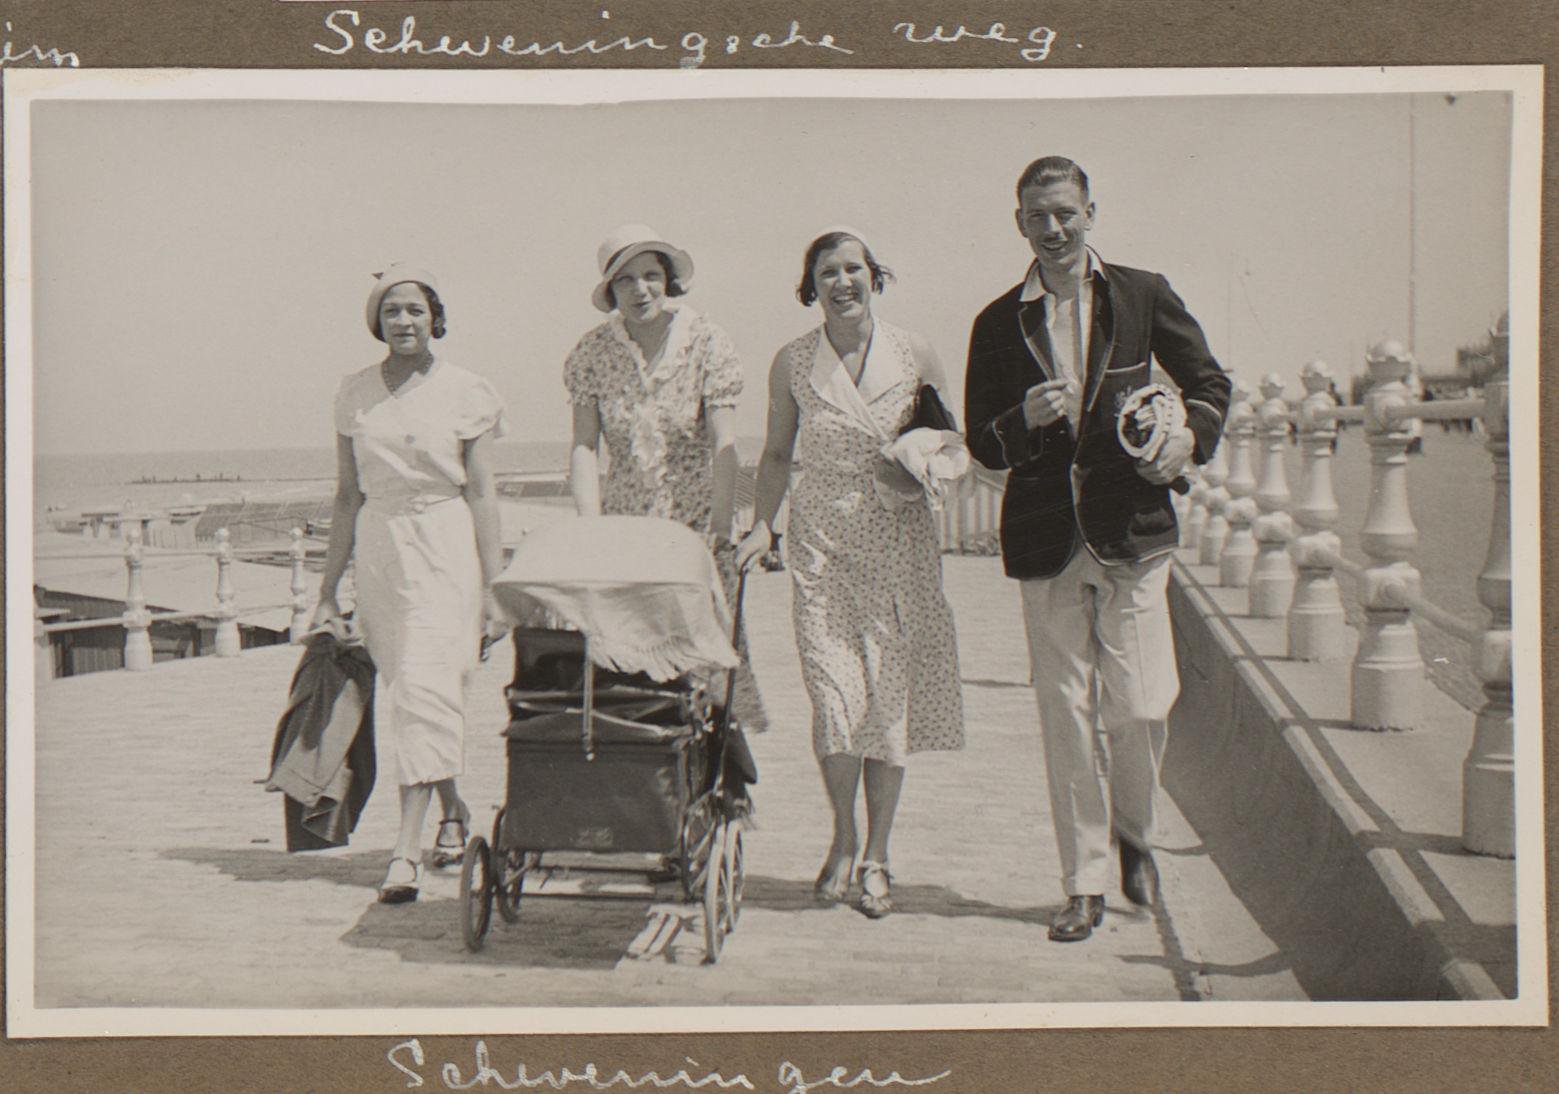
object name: photograph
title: Gezelschap lopend over de boulevard, Scheveningen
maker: Anonymous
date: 1932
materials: paper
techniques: gelatin silver print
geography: scheveningen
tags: the hague, wilhelmina van zijll de jong, strolling, avenue, boulevard, promenade, esplanade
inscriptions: inscription: ‘Scheveningen’